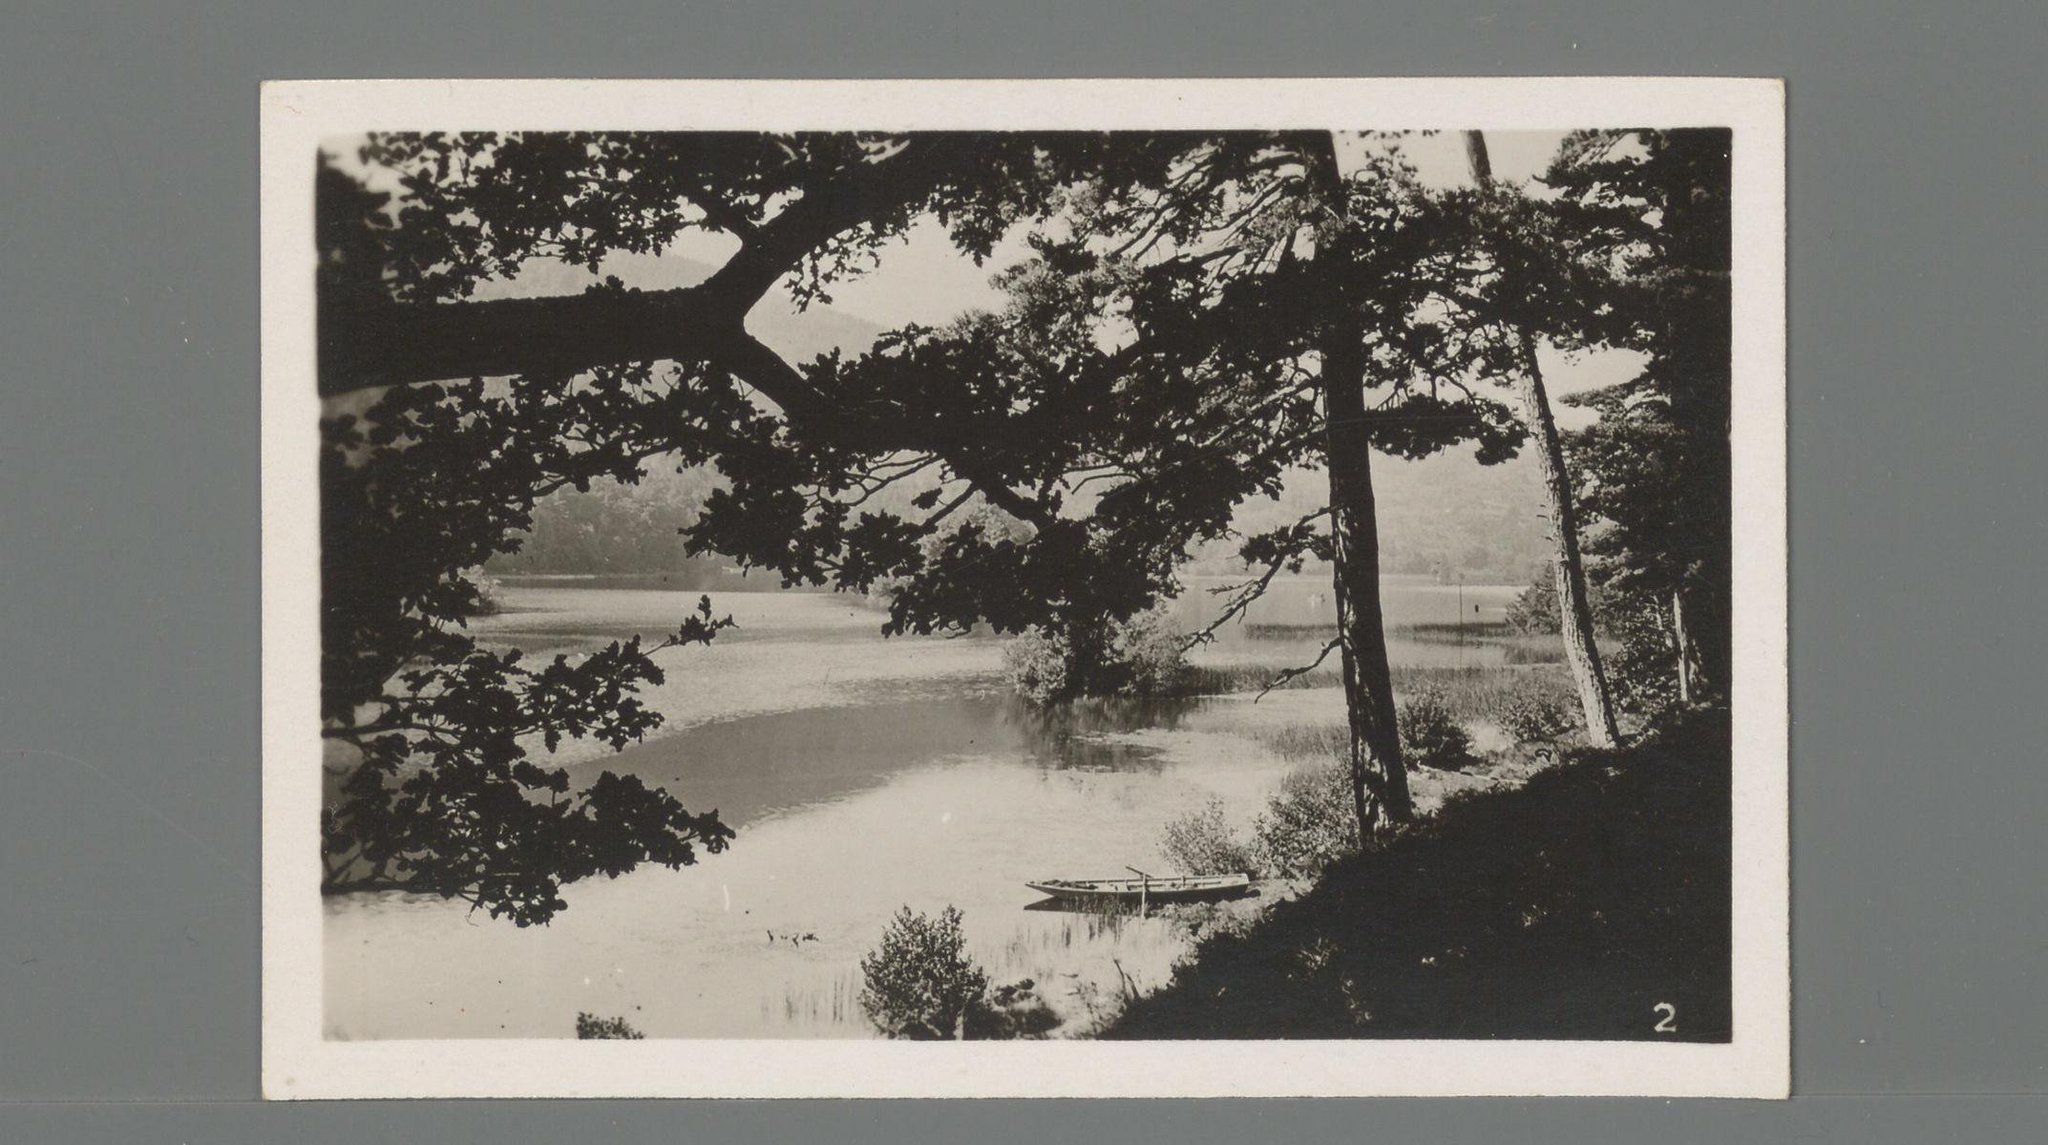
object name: photograph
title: Les bords du lac Chambon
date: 1920-1932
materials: photographic support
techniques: photography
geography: paris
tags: rowing-boat, canoe, etc., lake